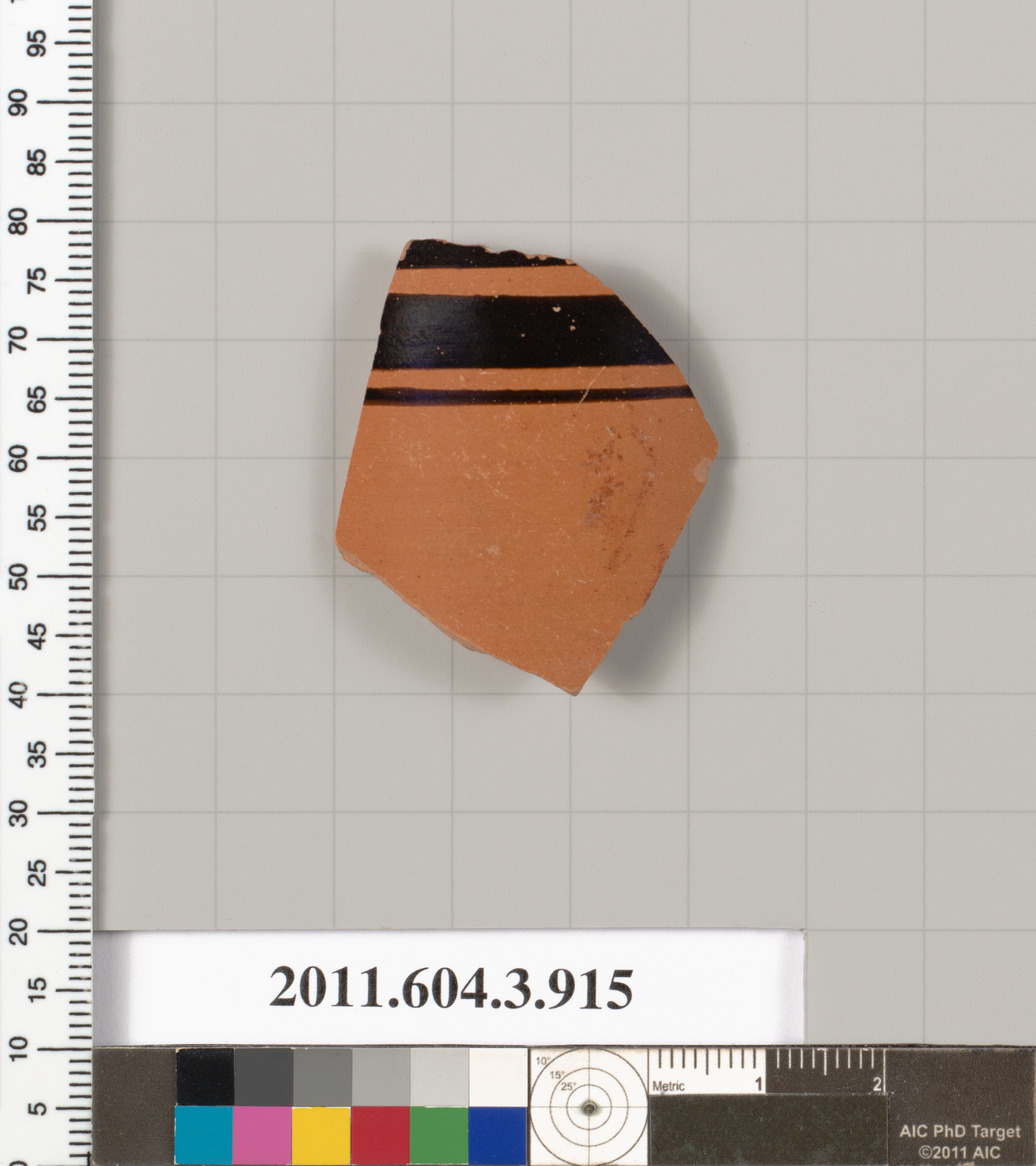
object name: lekythos fragment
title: Terracotta fragment of a lekythos (oil flask)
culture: greek, attic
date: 600-401 BCE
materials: terracotta